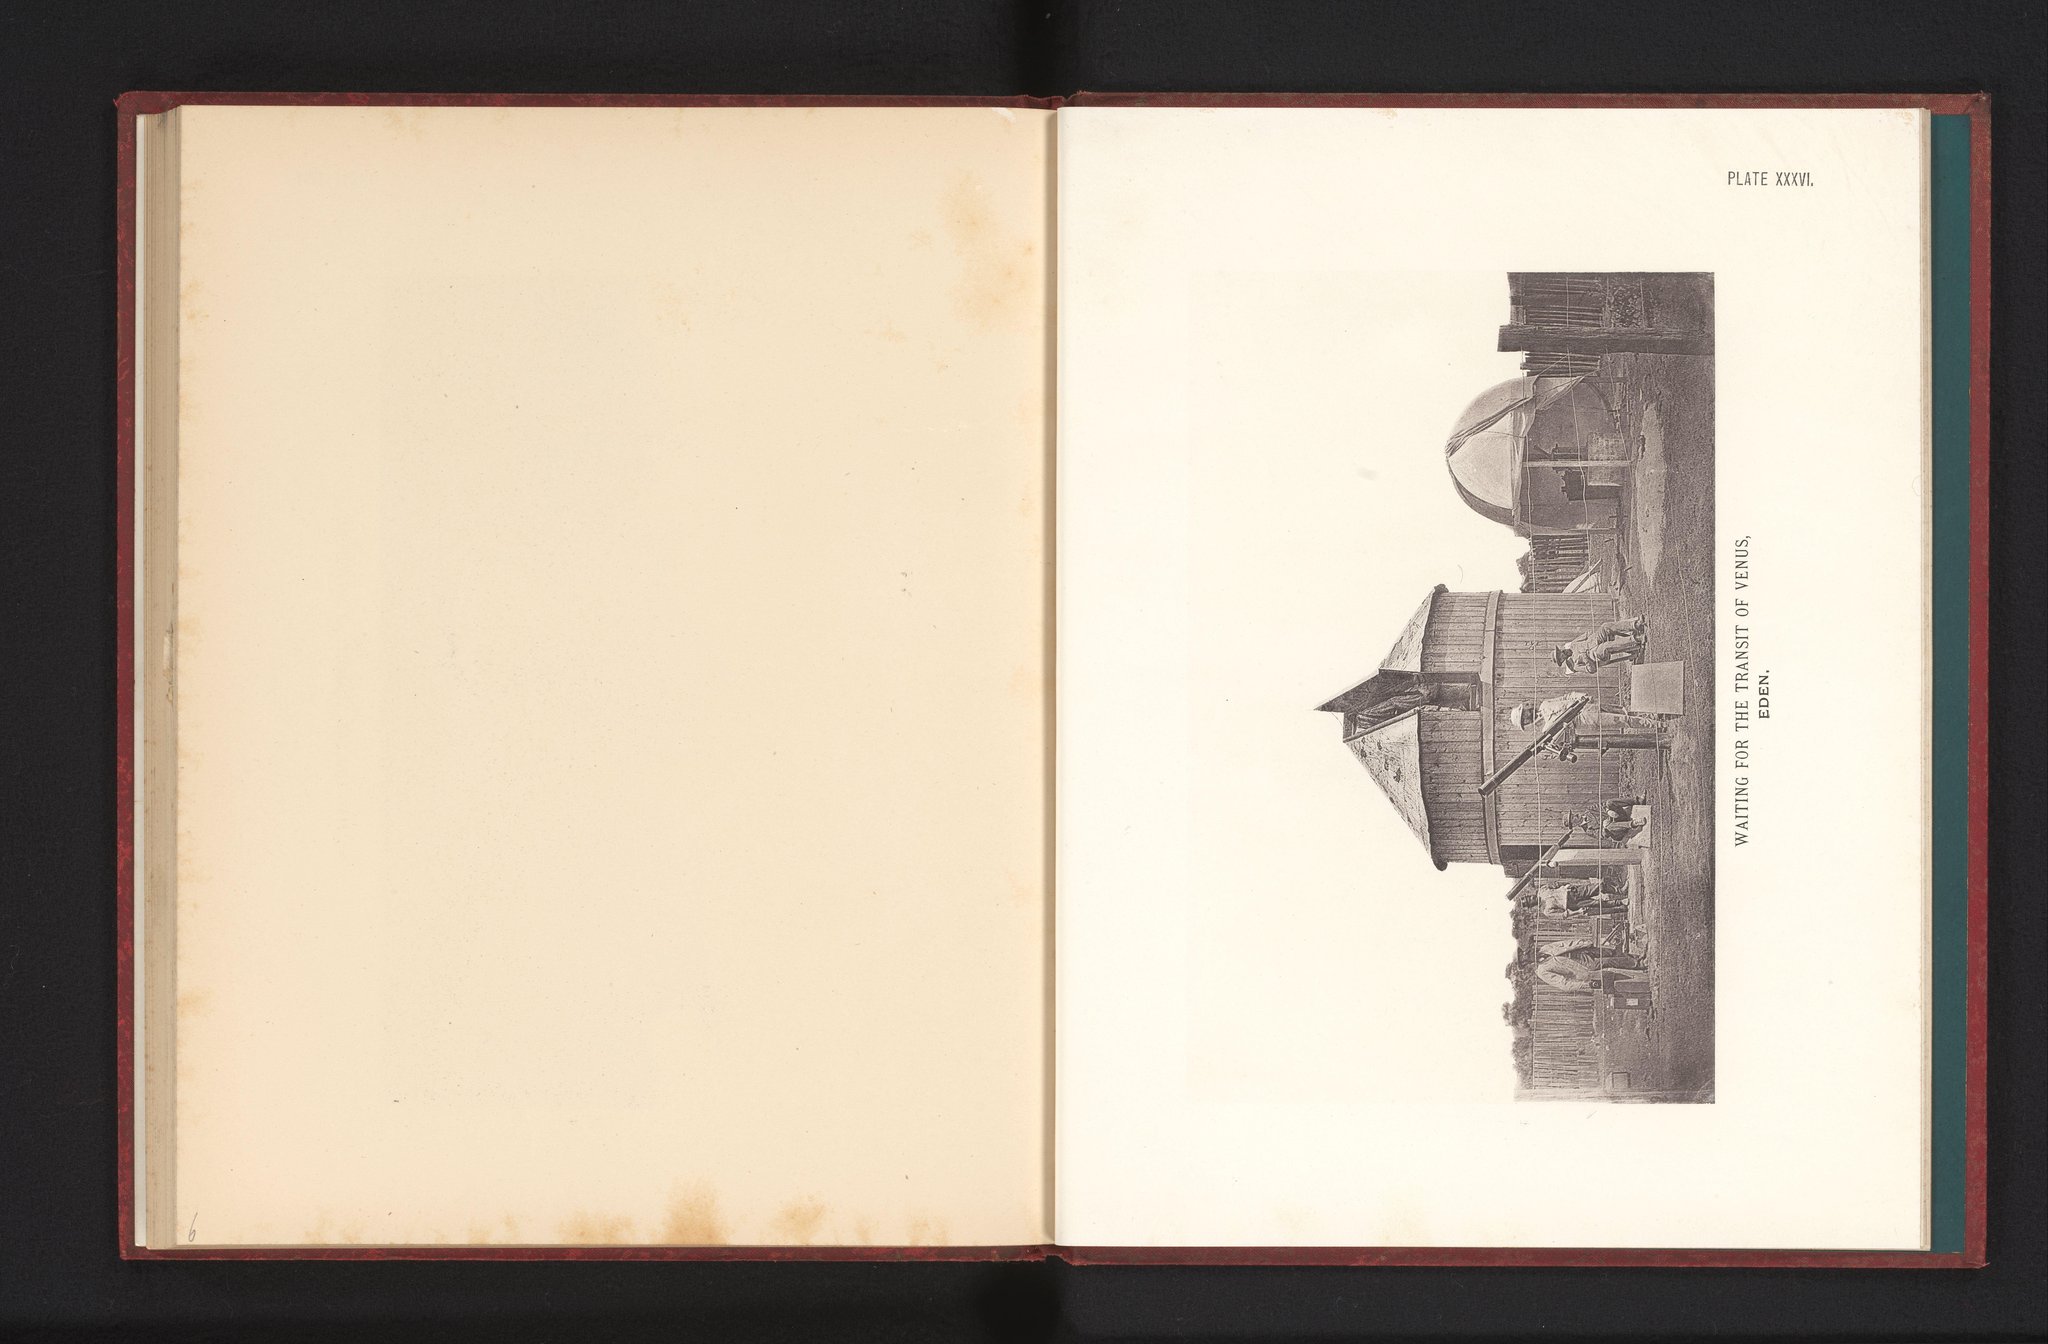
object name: photomechanical print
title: Waiting for the transit of Venus, Eden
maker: Anonymous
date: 1882-1892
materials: paper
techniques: photograph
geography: eden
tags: tent-camp, astronomical phenomena, astronomy (and cosmography)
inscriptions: number: ‘Plate XXXVI.’